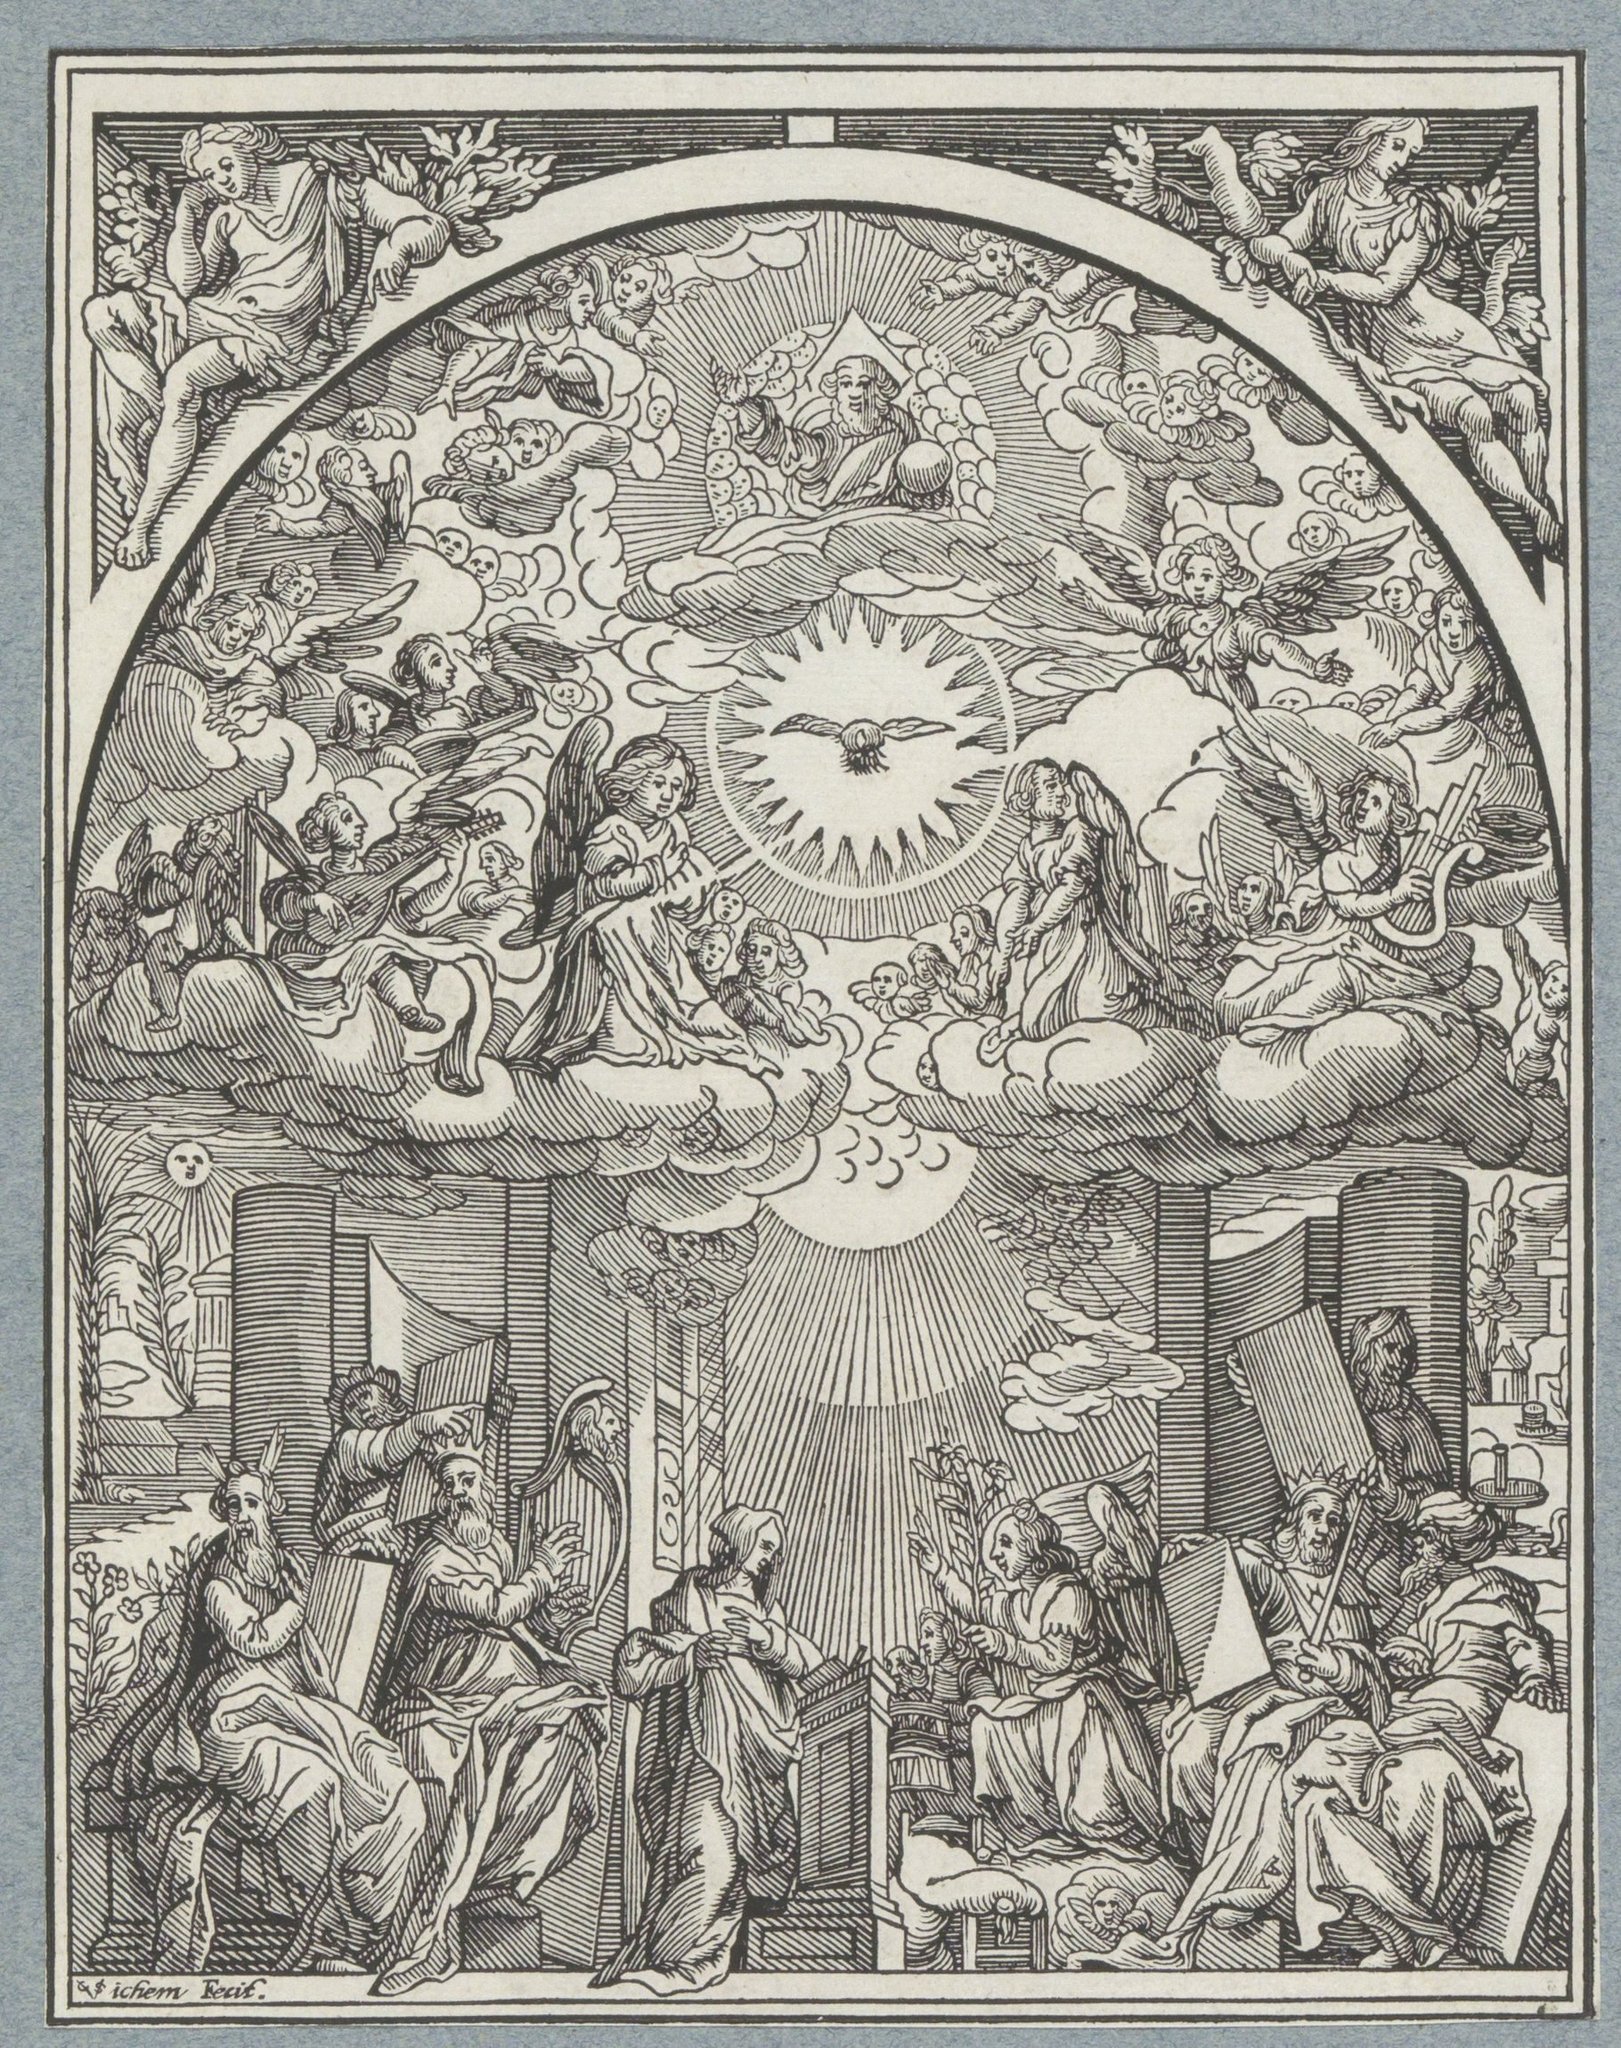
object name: print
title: Jeugd van Christus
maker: christoffel van sichem (ii)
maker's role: print maker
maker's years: 1581-1658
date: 1591-1657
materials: paper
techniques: woodcut, pasting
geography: amsterdam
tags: prefigurations of mary; mary and her prefigurations, god the father, the annunciation: mary, usually reading, is visited by the angel (sometimes a woman overhears the conversation), holy ghost represented as a dove (in flames)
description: In het midden de verkondiging aan Maria. Links daarvan Mozes, de profeet Jesaja en koning David en rechts koning Salomo en de profeten Jeremia en Haggai. Zij houden ieder een tablet vast. Uiterst links en rechts landschappen met symbolen voor de onbevlekte ontvangenis en zuiverheid van Maria. Onder andere een gesloten tuin, lelies, een bron en een gesloten poort. Midden boven God de Vader en de duif van de Heilige Geest. Op de wolken aanbiddende engelen. De prent maakt deel uit van een album.